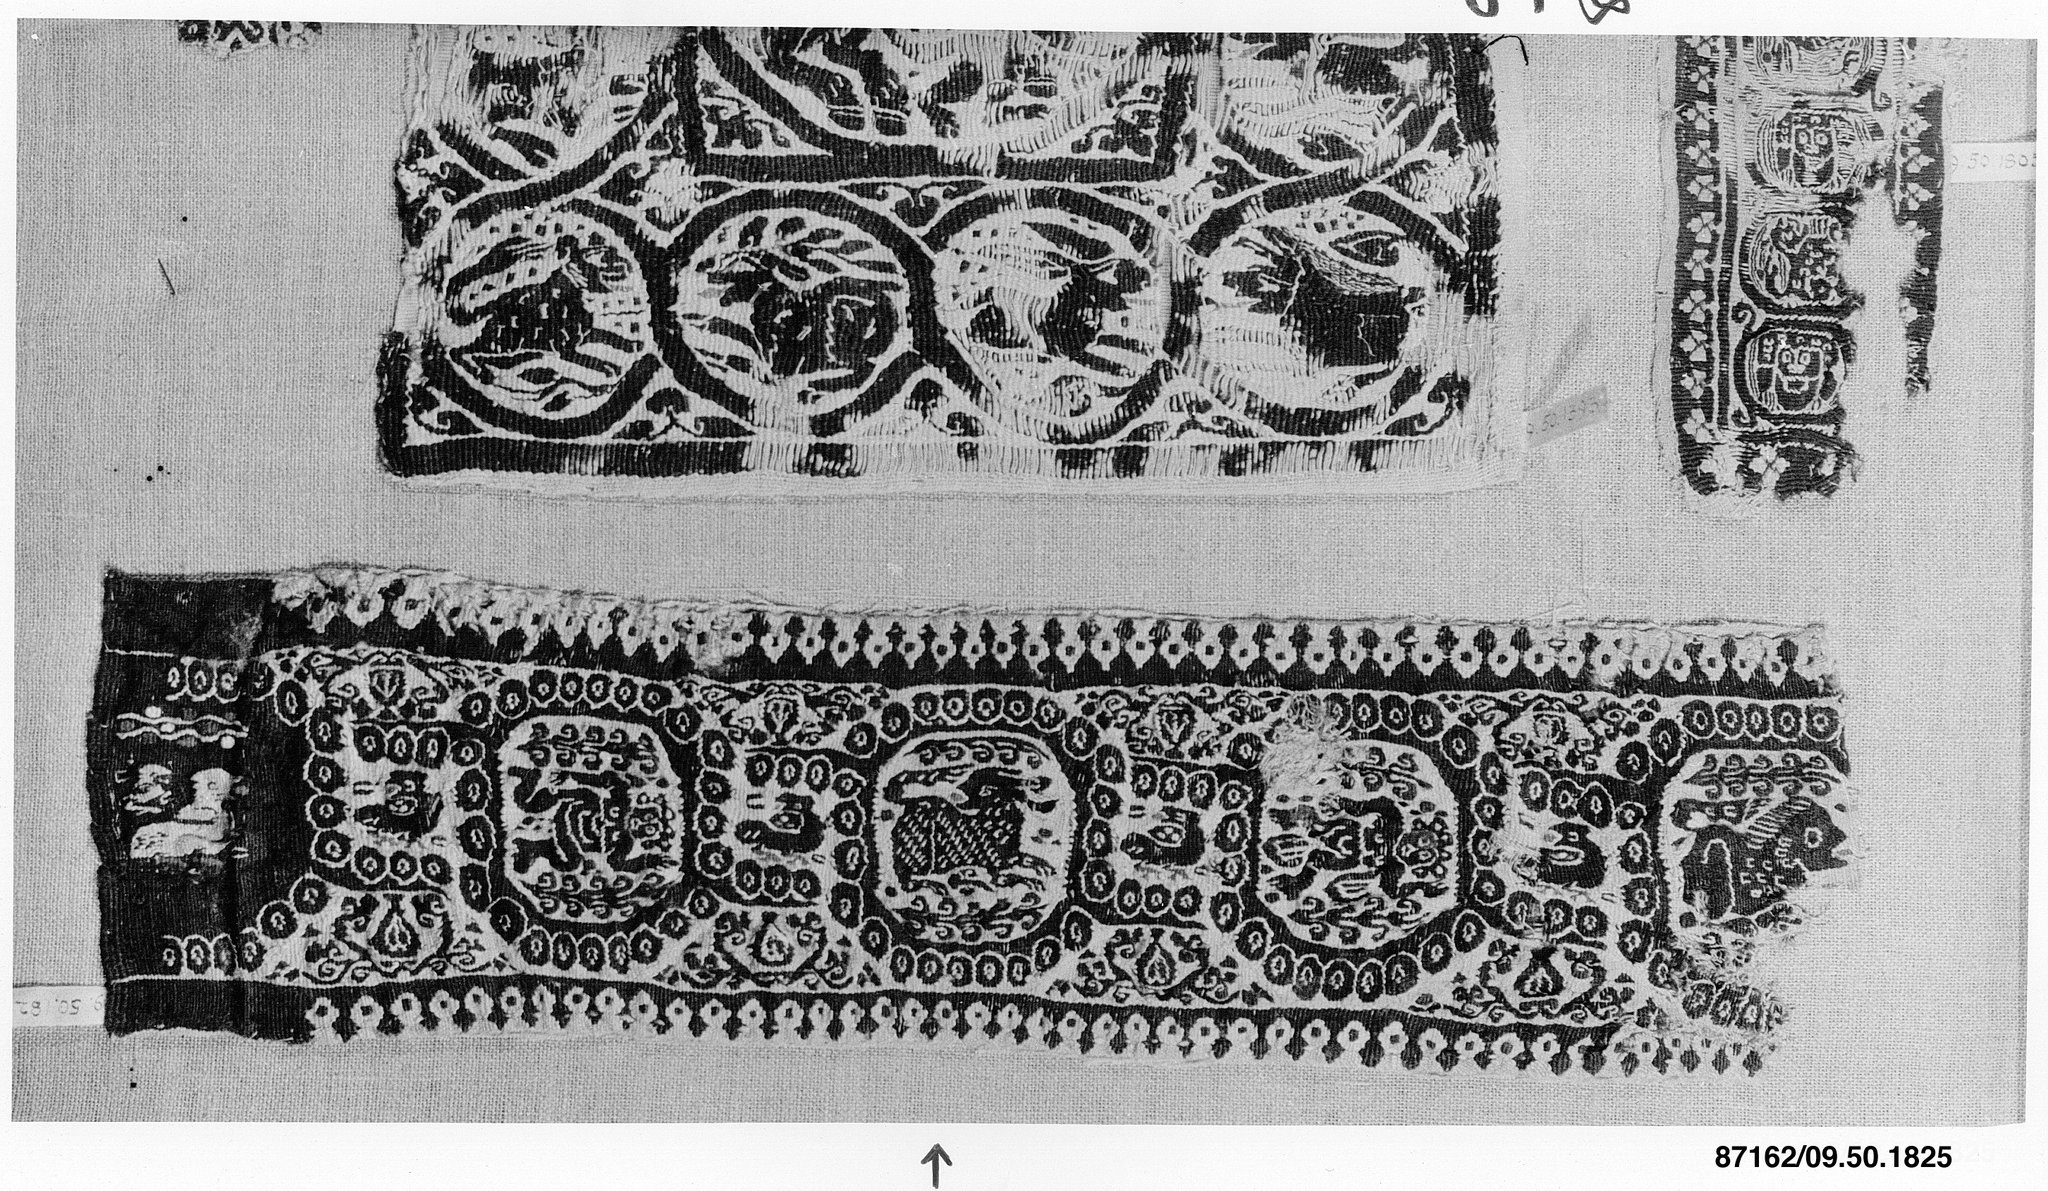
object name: band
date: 301-500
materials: linen, wool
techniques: weave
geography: egypt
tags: human figures,animals